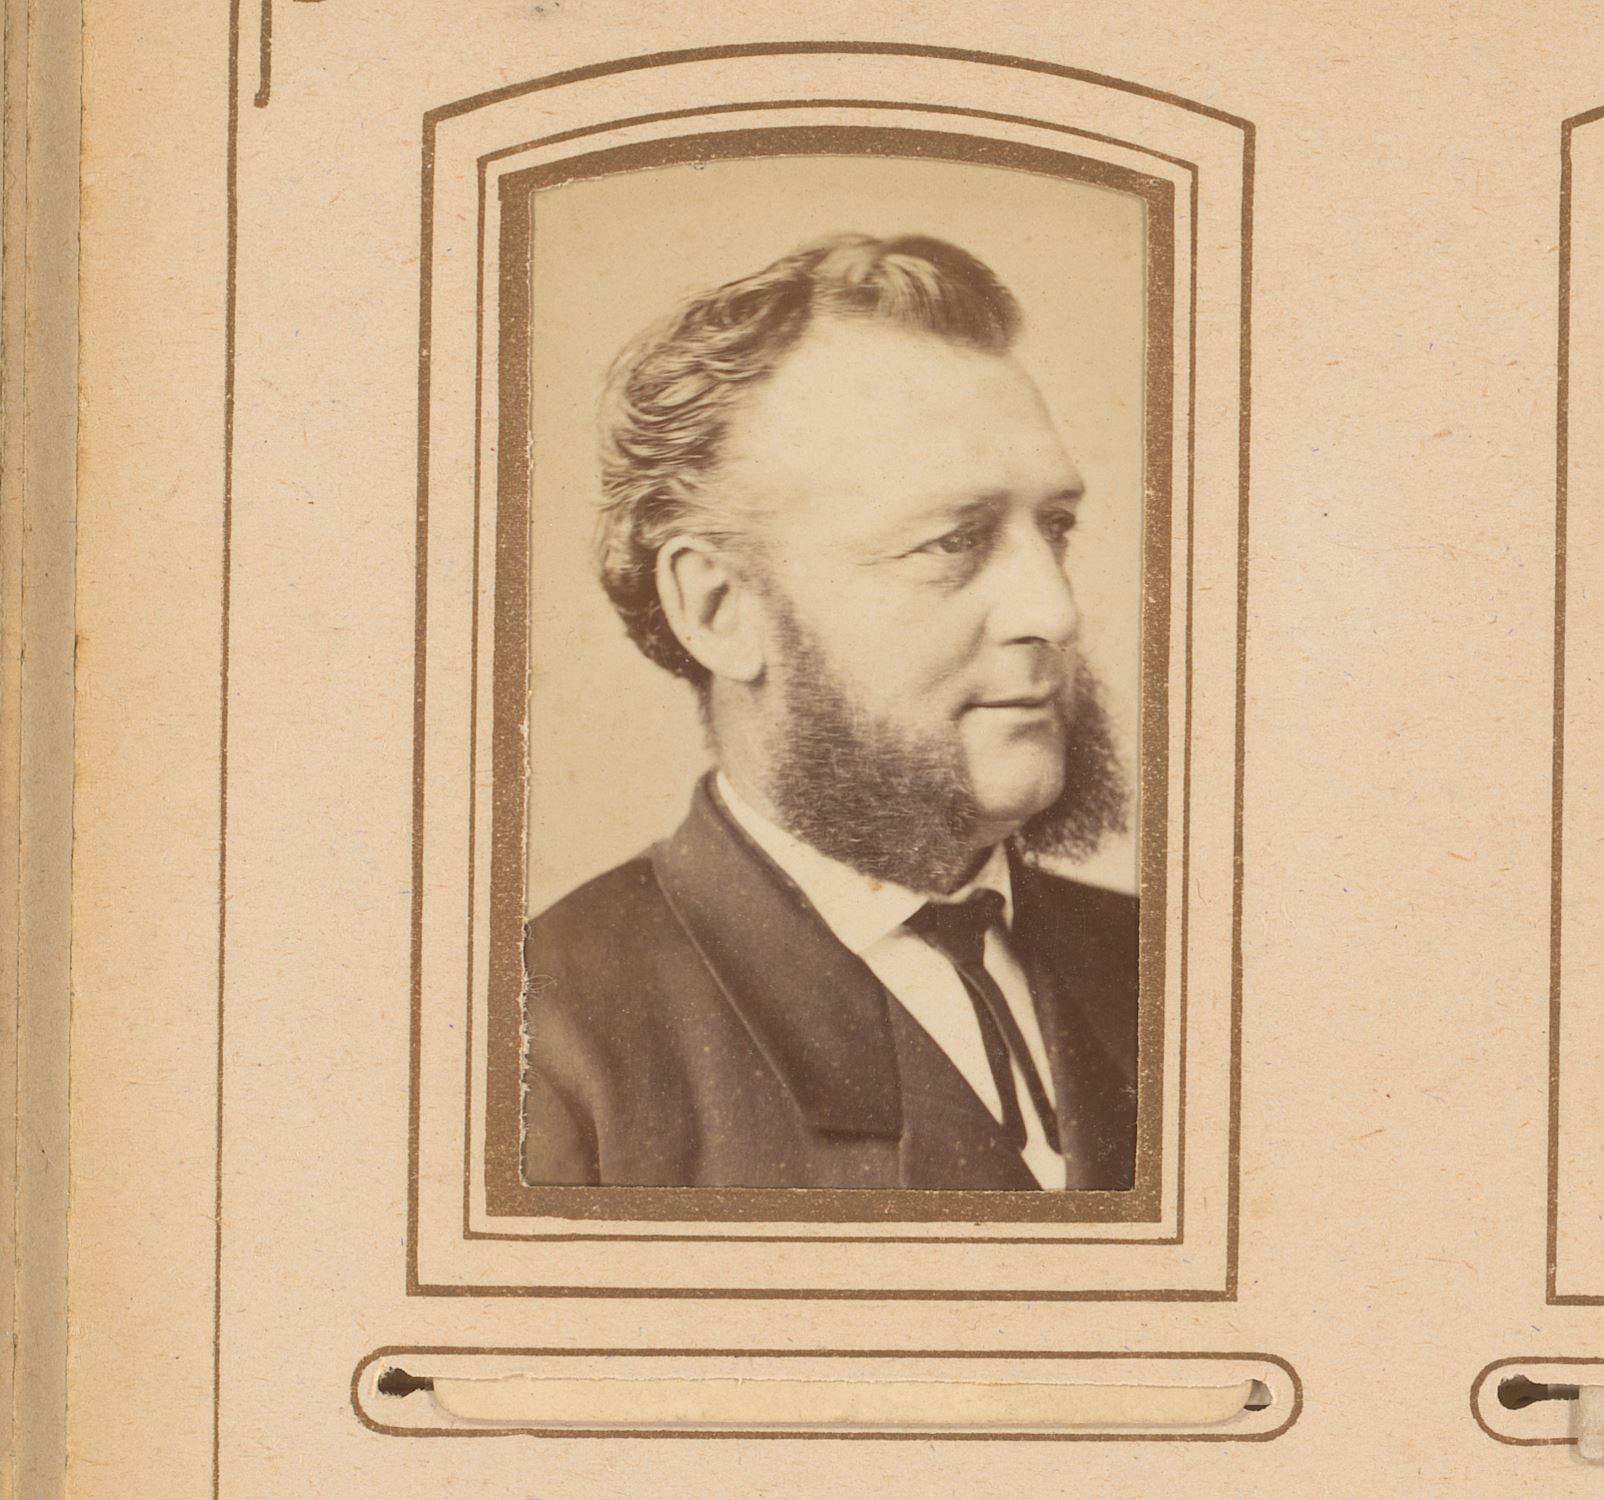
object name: photograph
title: Portret van een man met bakkenbaarden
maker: bernardus bruining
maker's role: fotograaf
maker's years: 1834-1900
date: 1875-1877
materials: cardboard, photographic support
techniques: albumen print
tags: sideburns, adult man, historical persons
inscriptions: inscription: ‘B. Bruining/ te Leiden/ Photographe/ Z.K.H. Prins Frederik/ Der Nederlanden’